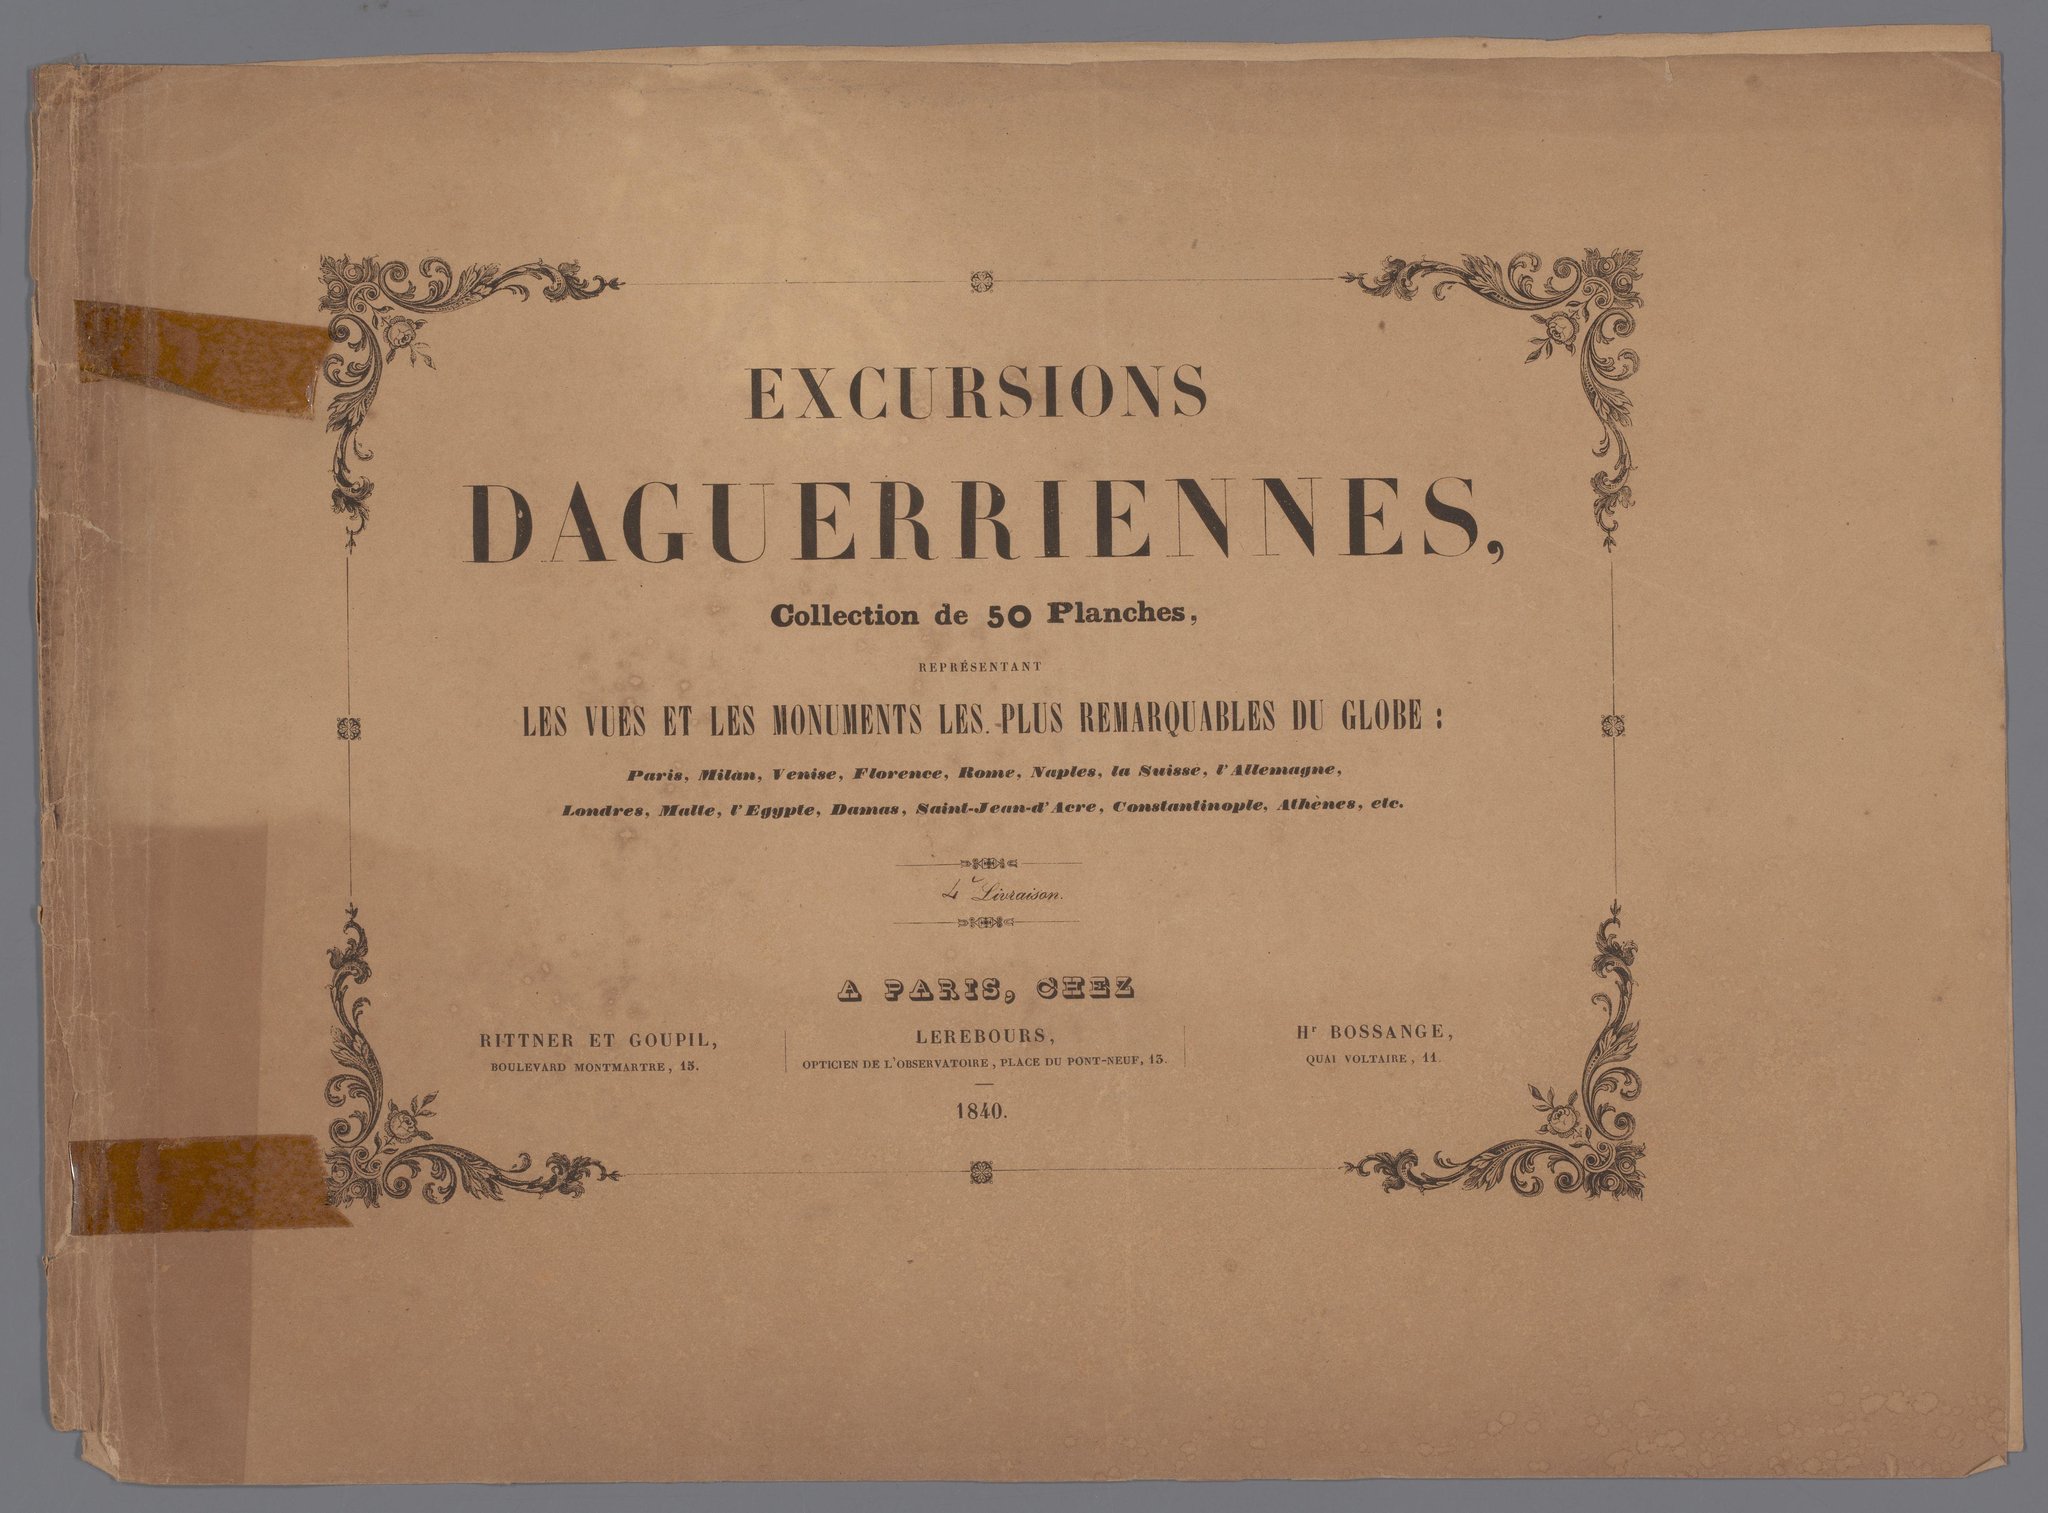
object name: print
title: 'Excursions daguerriennes' omslagpagina's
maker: Anonymous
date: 1840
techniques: engraving